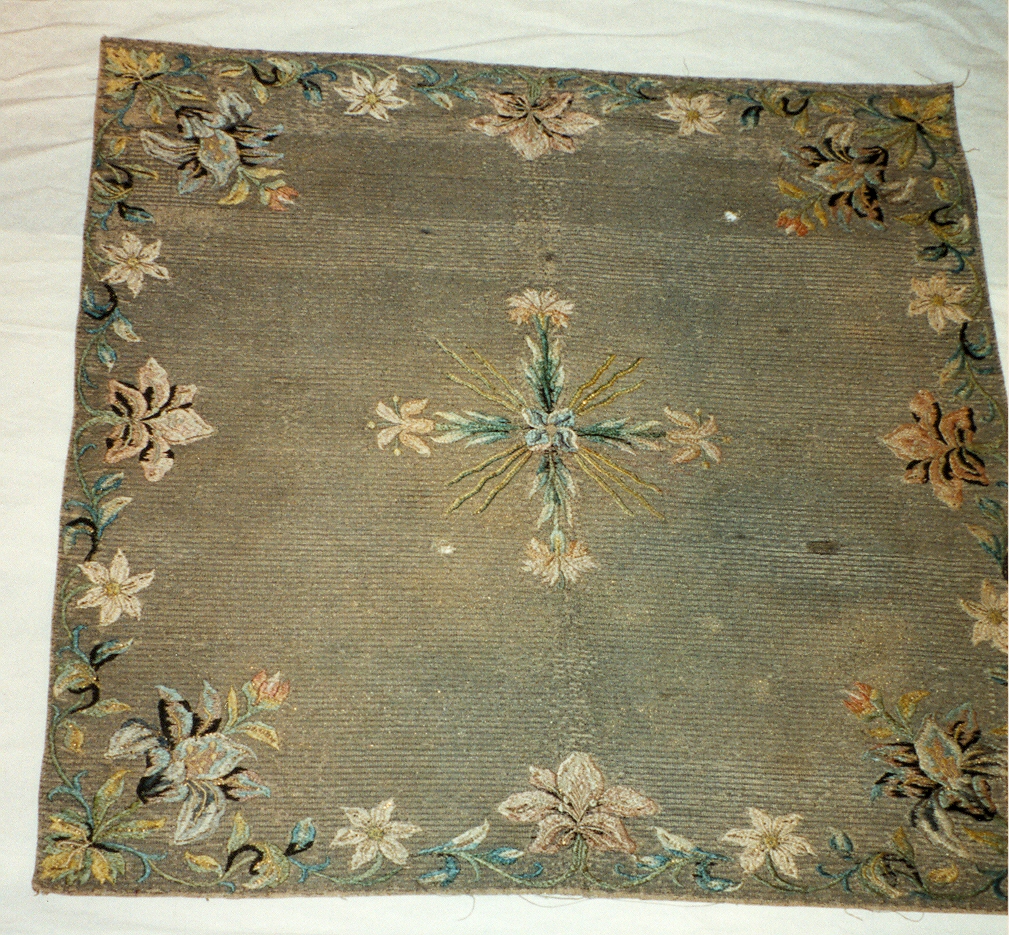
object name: chalice veil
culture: french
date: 1701-1800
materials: metal, silk